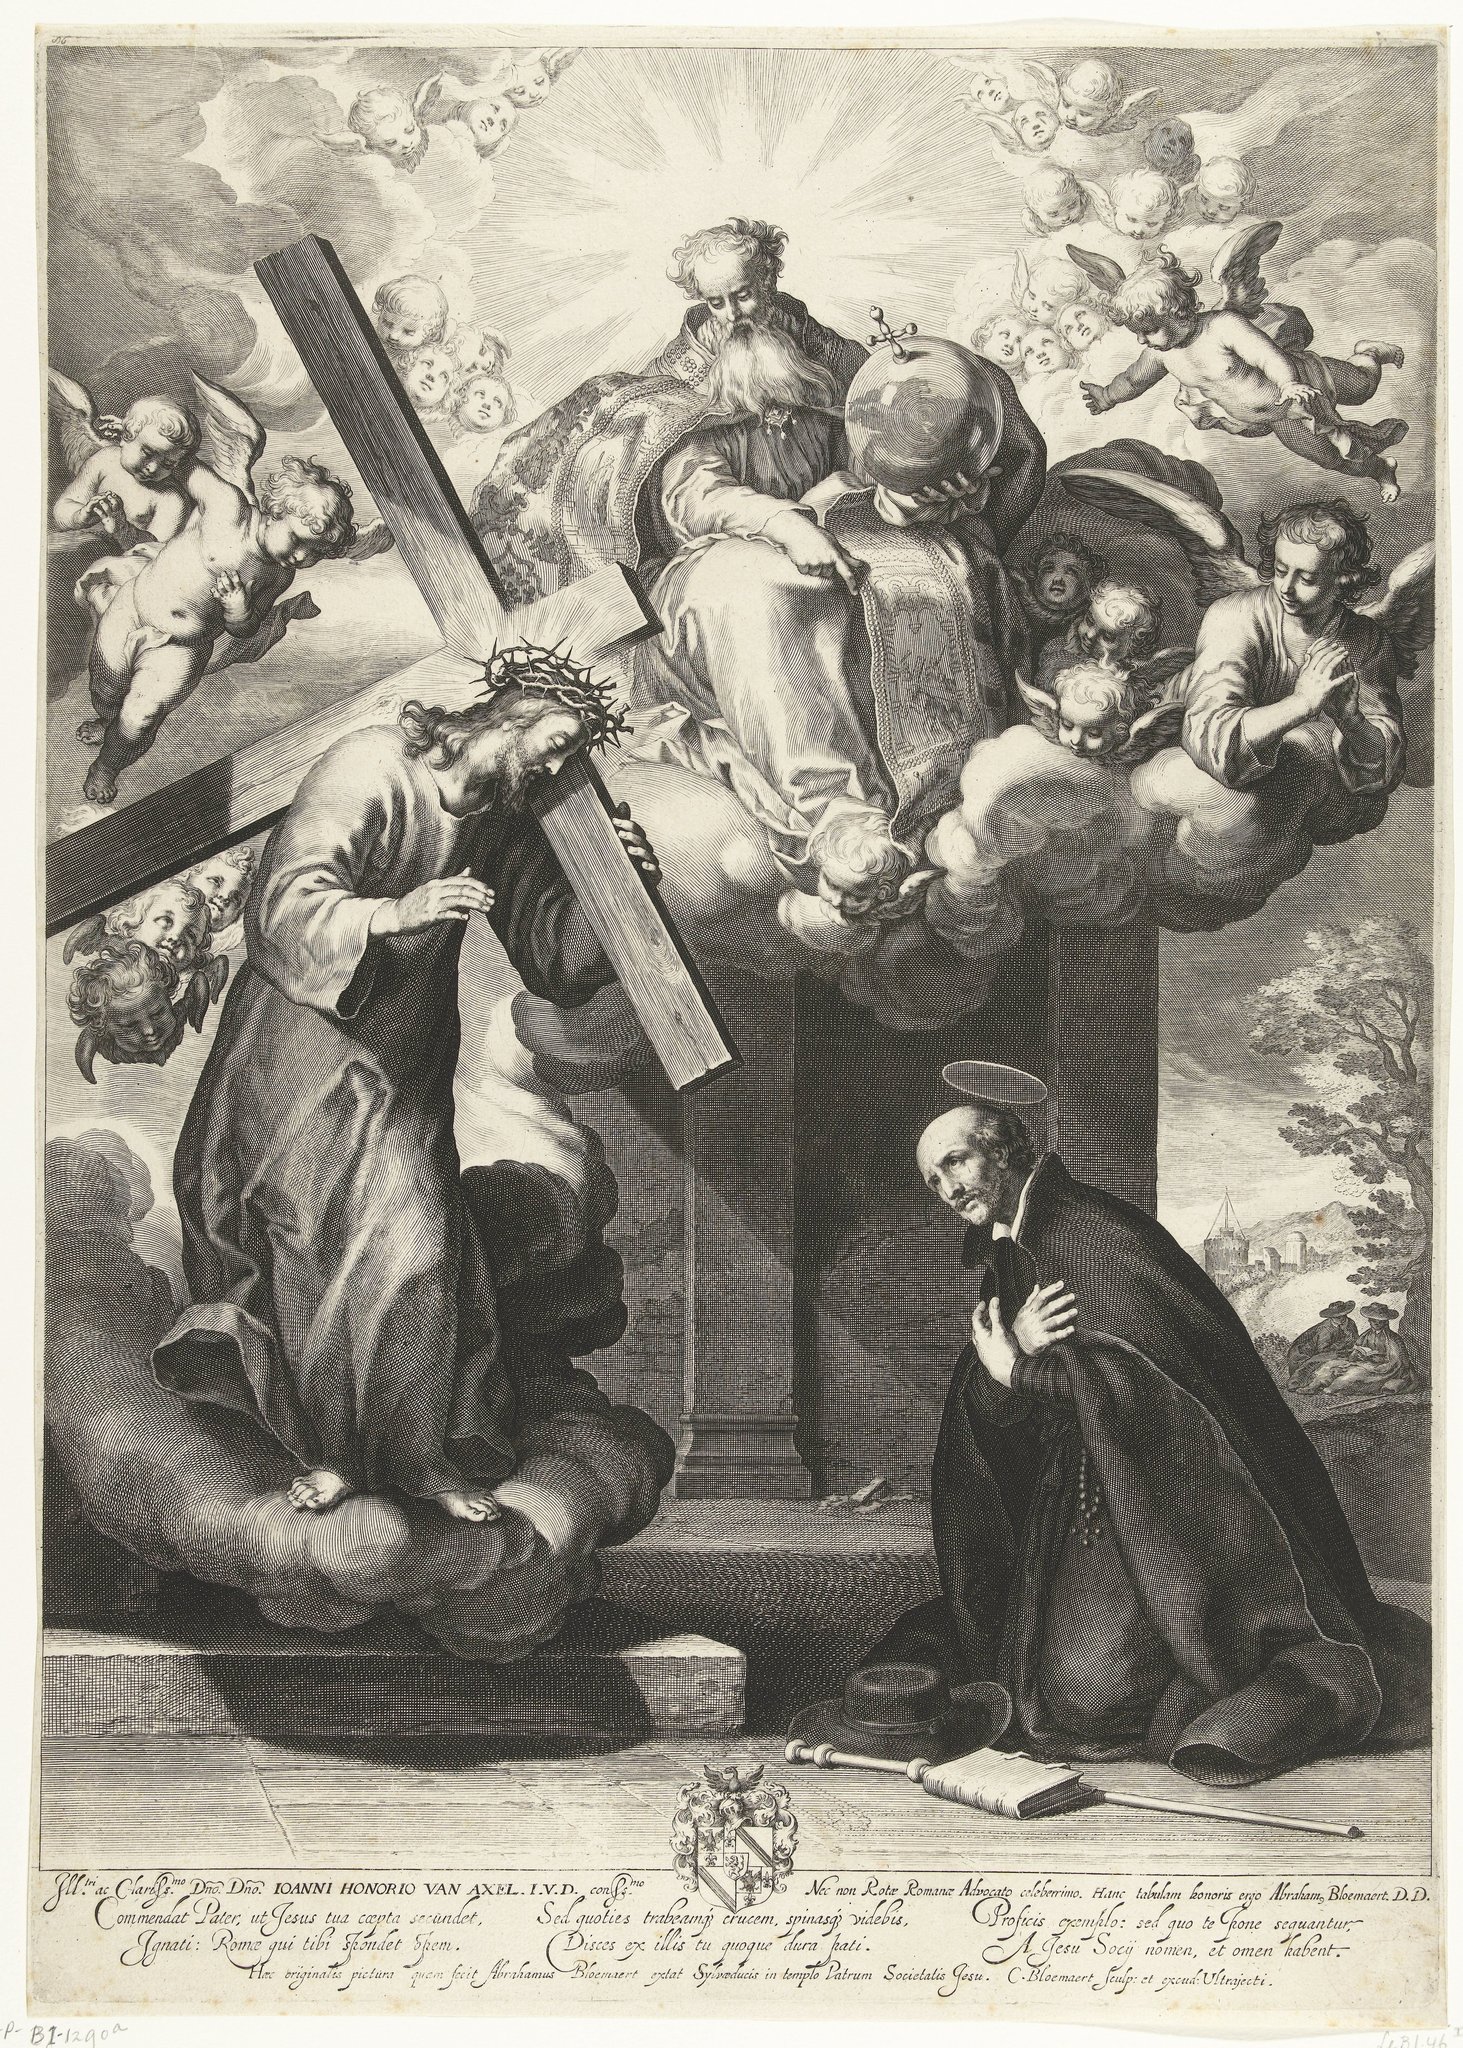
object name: print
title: Het visioen van de heilige Ignatius van Loyola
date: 1622-1630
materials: paper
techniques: engraving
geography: utrecht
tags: visions of st. ignatius of loyola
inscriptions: collector's mark: Lugt 240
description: Ignatius van Loyola afgebeeld als een man van middelbare leeftijd, met het zwarte habijt van de Jezuïtenorde, biddend in een kapel langs de kant van de weg. Voor hem verschijnt Christus die het kruis draagt.